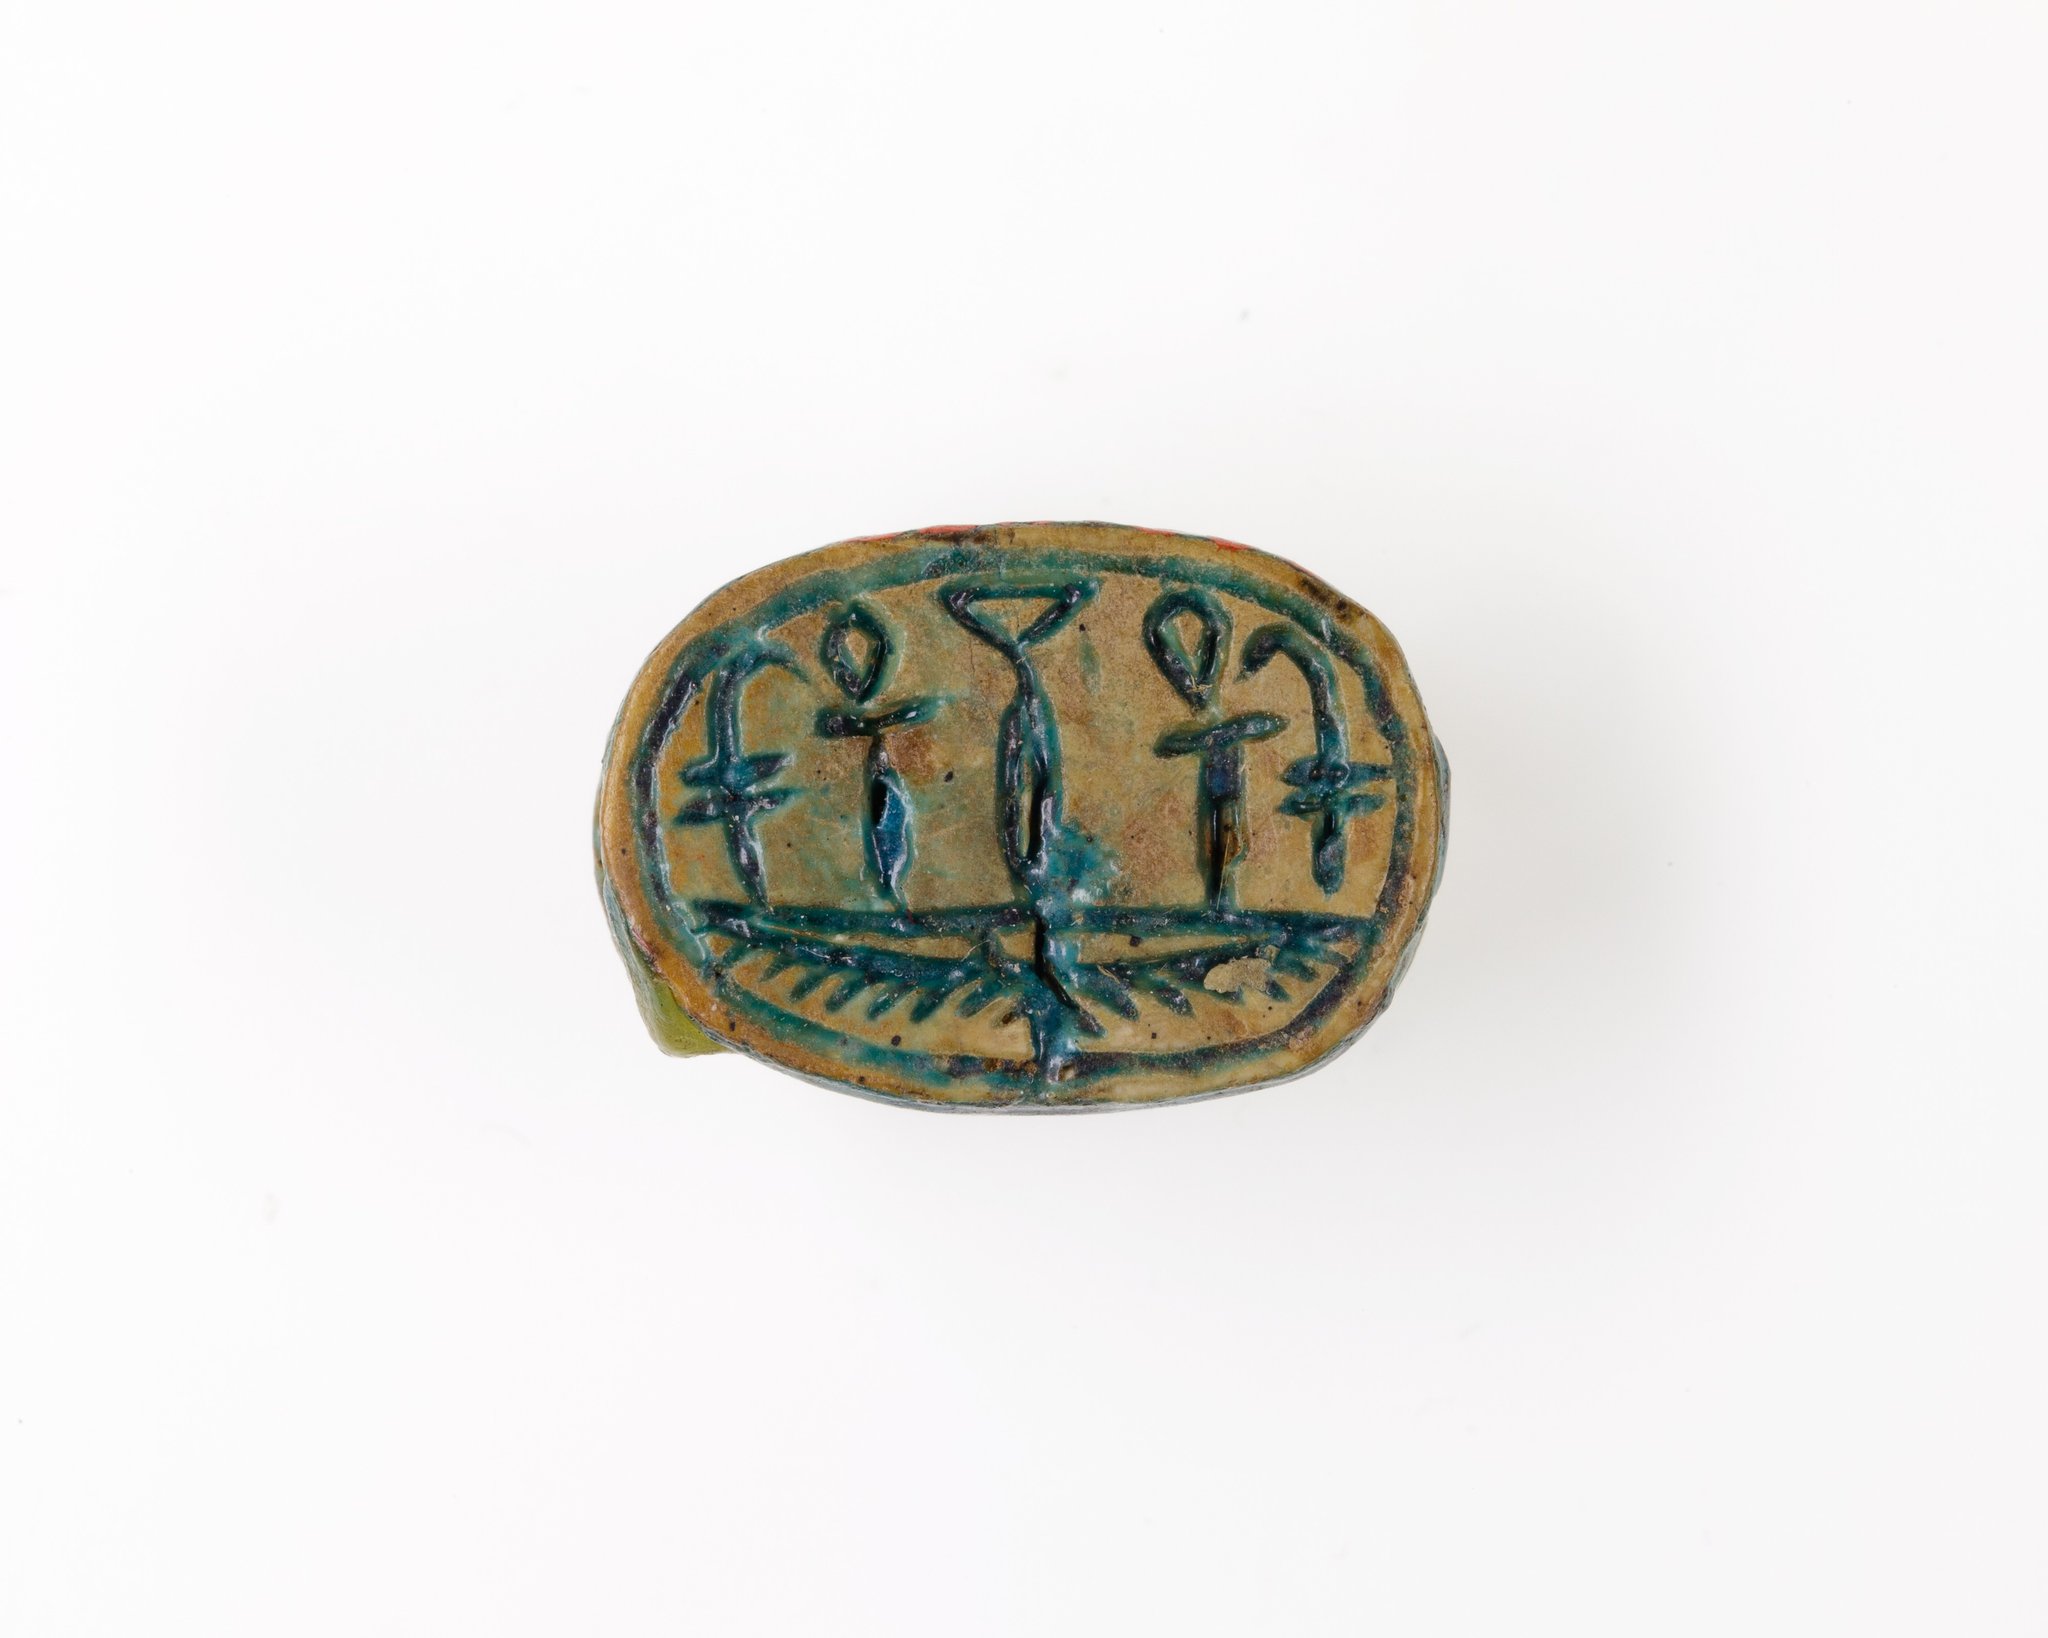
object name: scarab, hieroglyph, winged sun, wadj, ankh, nswt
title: Scarab Inscribed with Hieroglyphs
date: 1640-1550 BCE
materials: stone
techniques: glazing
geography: egypt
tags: hieroglyphs,scarabs